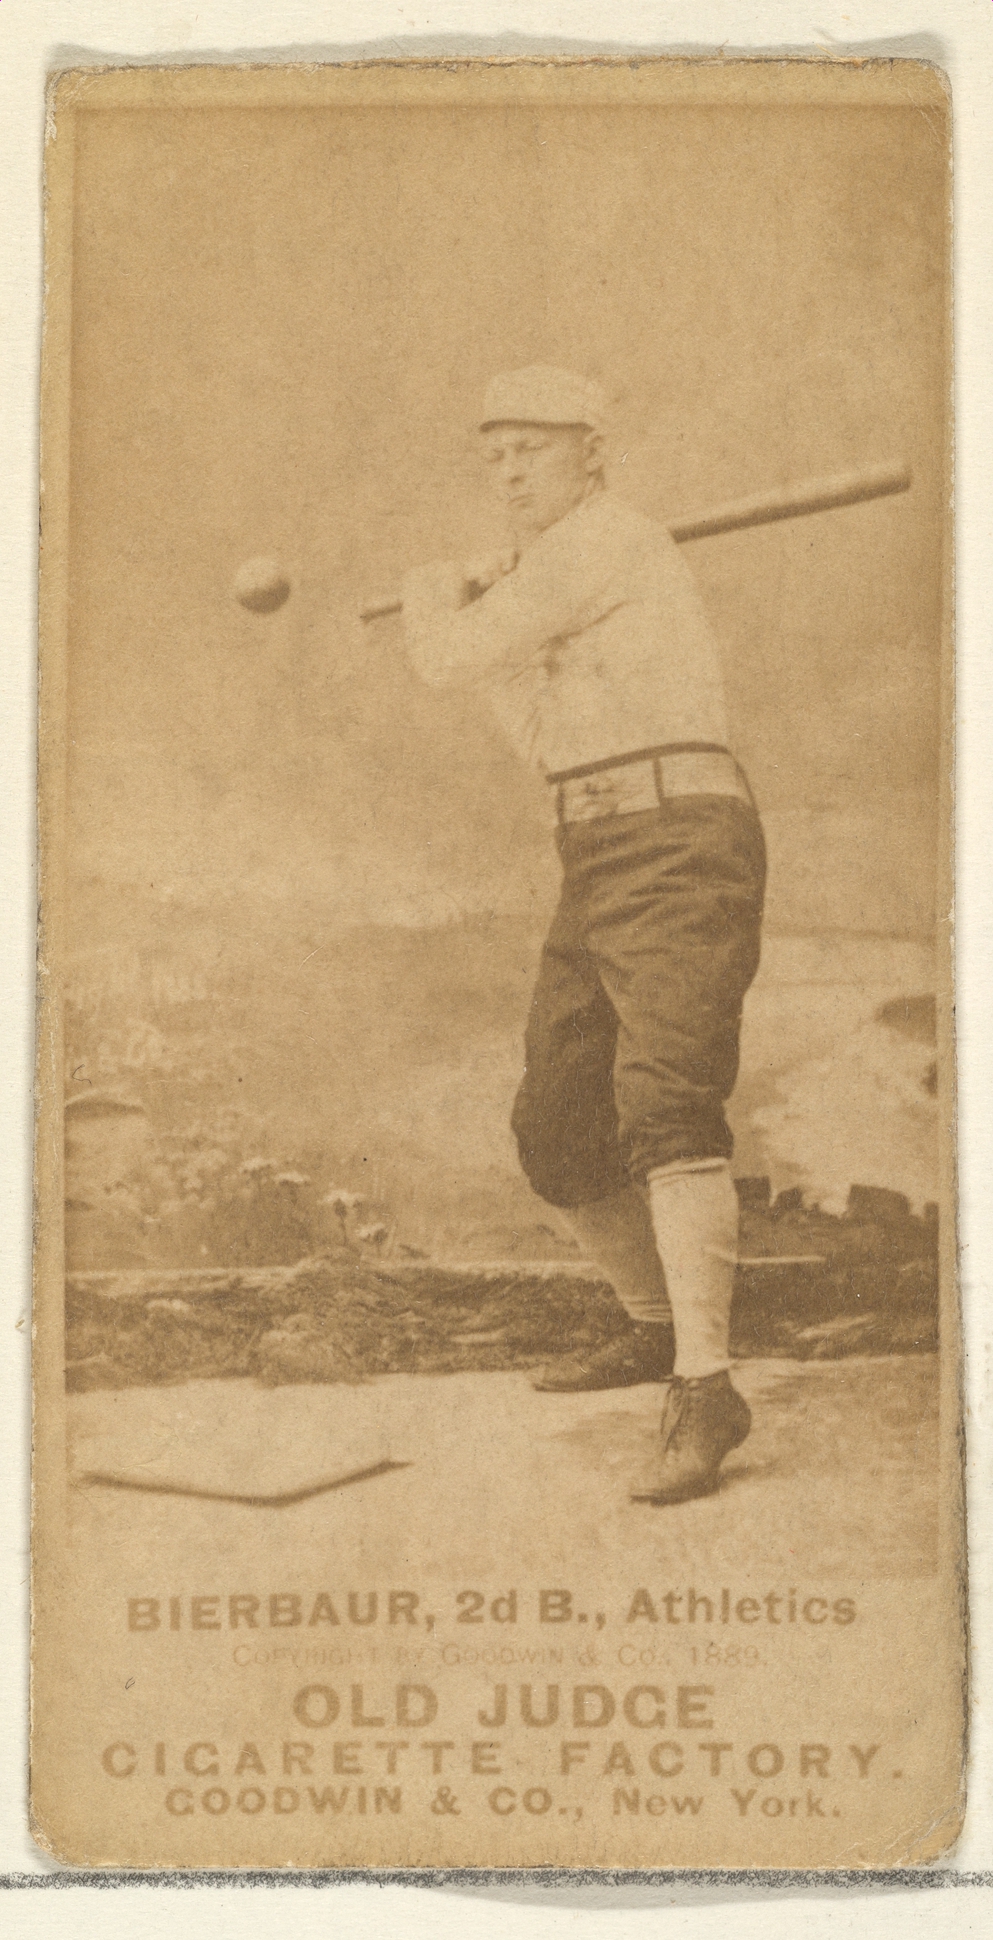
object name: baseball card, photograph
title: Bierbauer, 2nd Base, Philadelphia Athletics, from the Old Judge series (N172) for Old Judge Cigarettes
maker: goodwin & company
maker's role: publisher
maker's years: 1850-1950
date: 1889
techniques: albumen silver print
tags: men,portraits,baseball,athletes